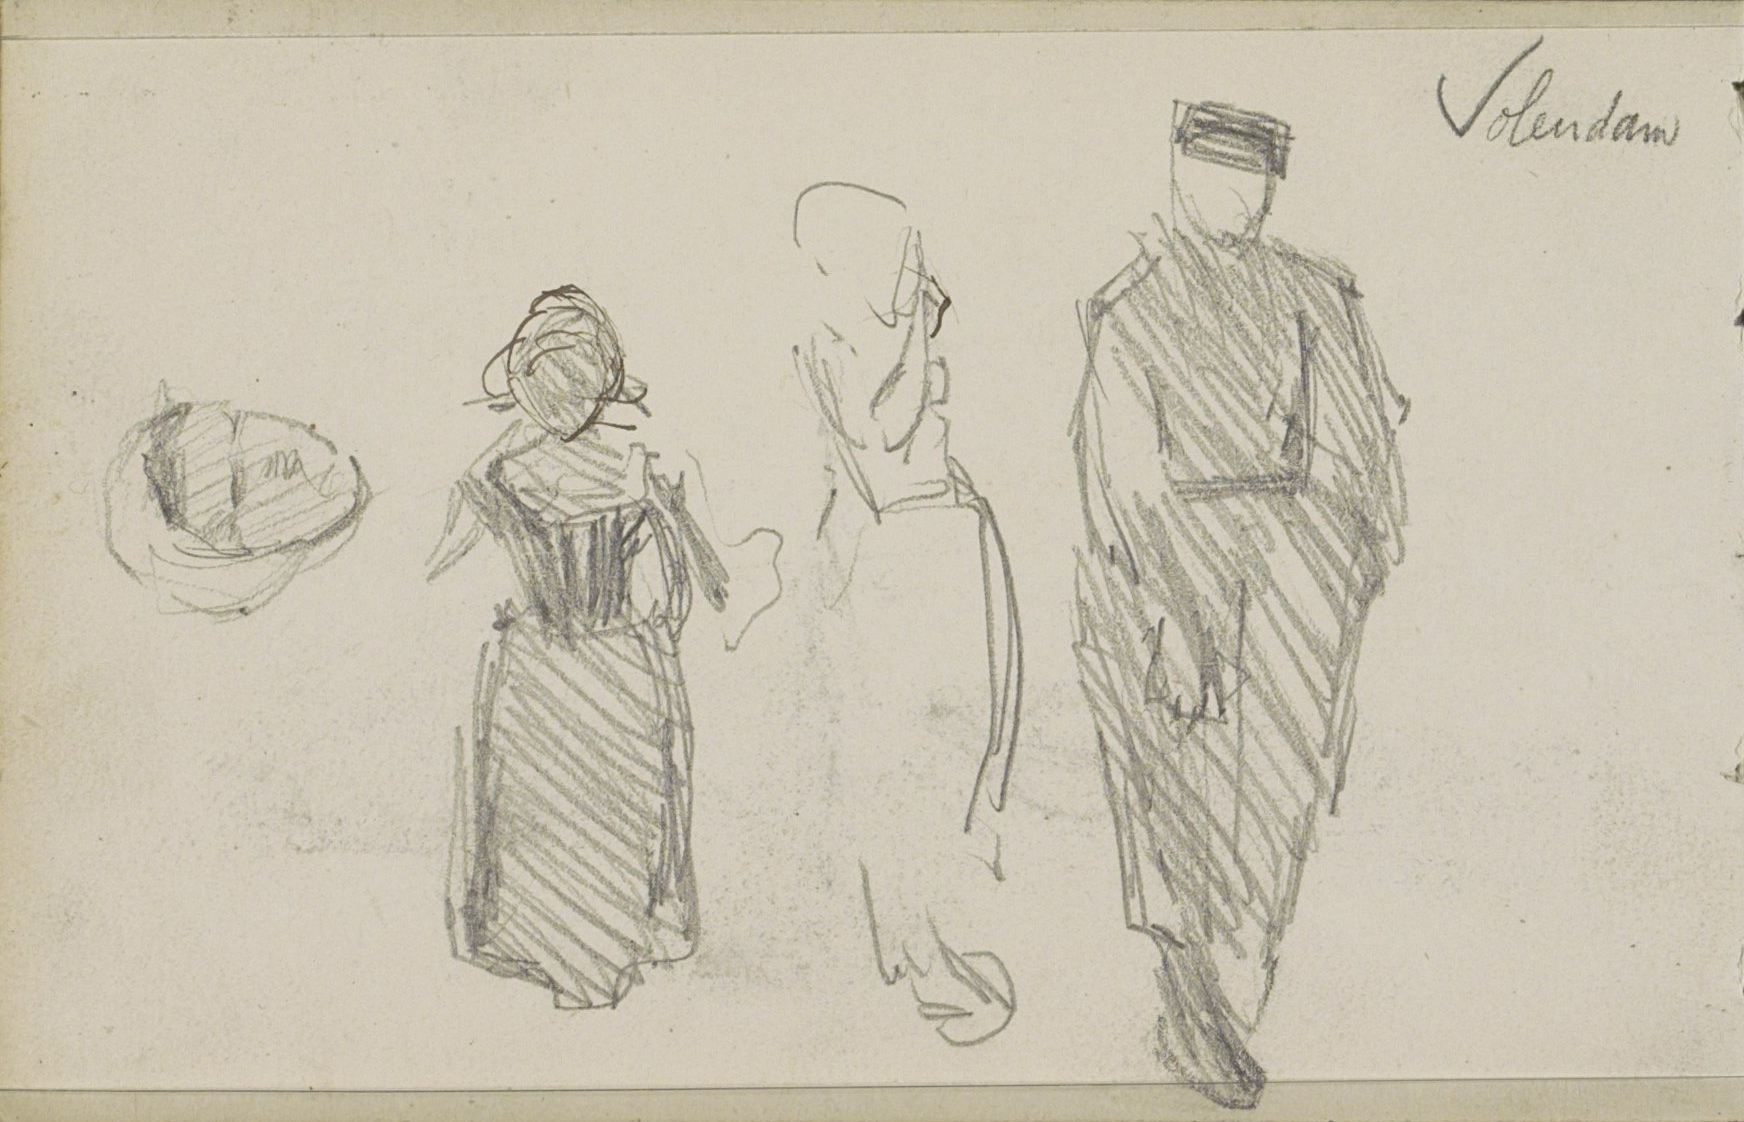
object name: sketchbook leaf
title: Man en vrouwen in Volendamse klederdracht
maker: george clausen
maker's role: draughtsman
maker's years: 1852-1912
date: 1875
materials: ink, paper, pencil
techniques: pen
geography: volendam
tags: adult woman, adult man, folk costume, regional costume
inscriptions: annotation: ‘Volendam’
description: Blad 5 verso uit een schetsboek met 38 bladen.